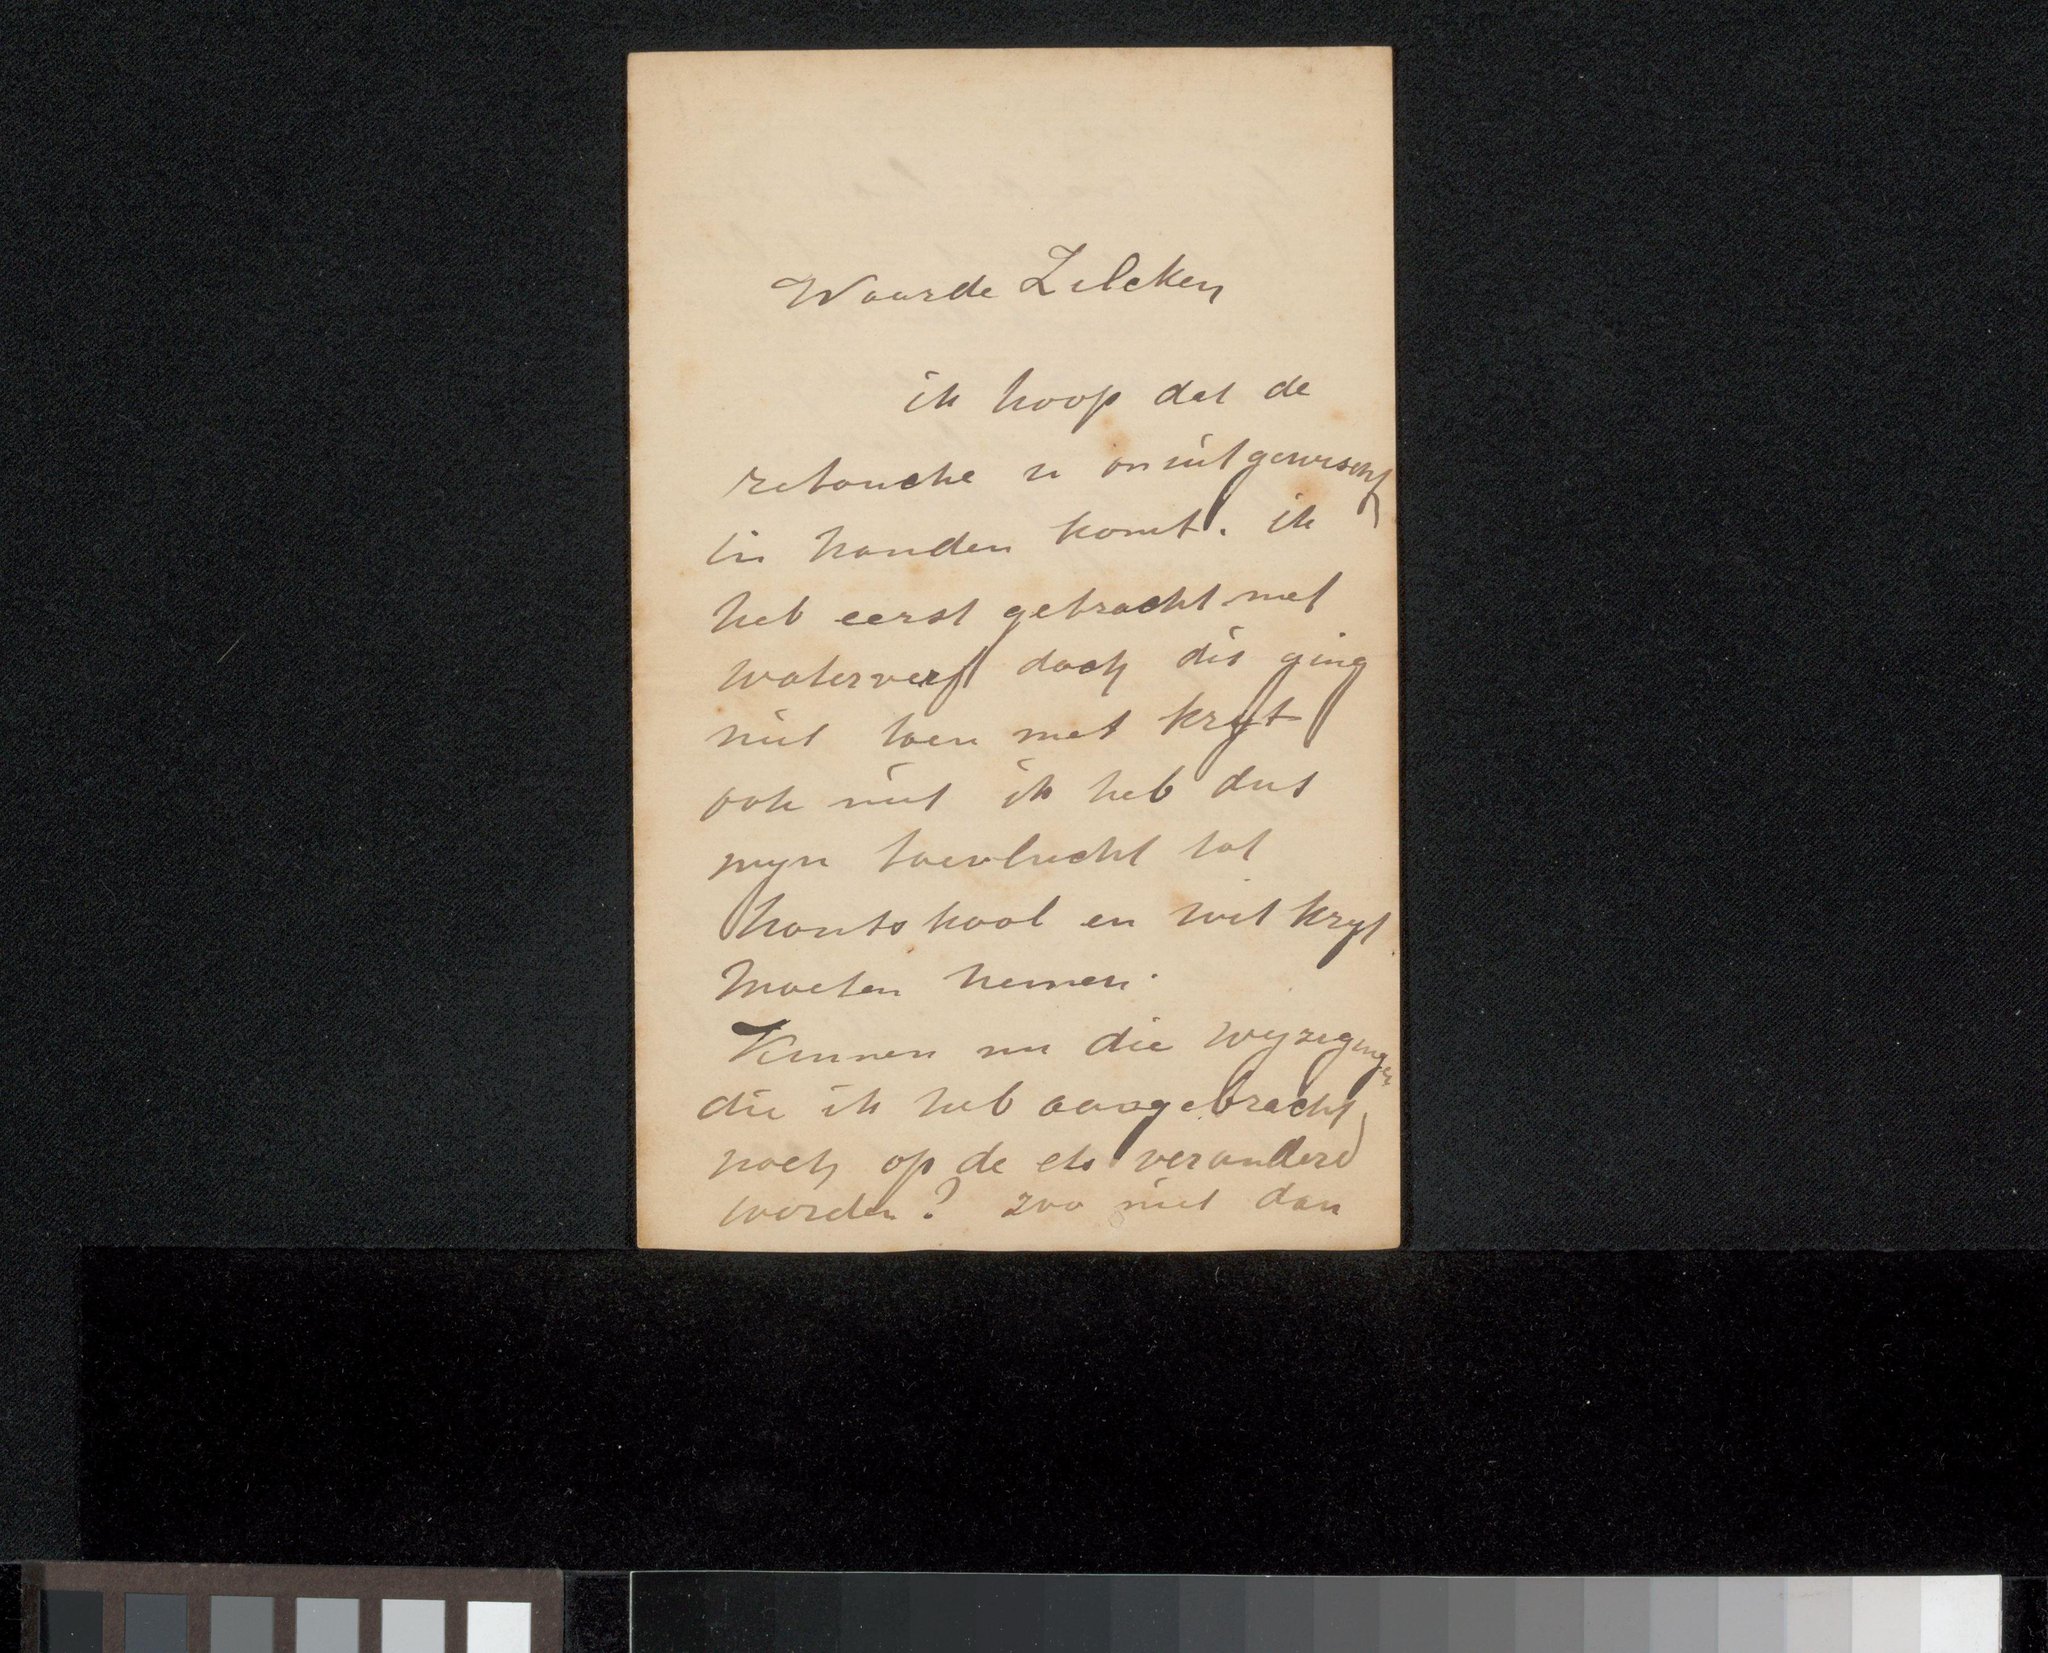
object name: letter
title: Brief aan Philip Zilcken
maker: jacob maris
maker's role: draughtsman, painter, print maker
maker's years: 1837-1899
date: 1885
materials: ink, paper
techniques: pen, writing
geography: the hague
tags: philip zilcken, drawing, the graphic arts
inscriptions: collector's mark: ‘RPK’